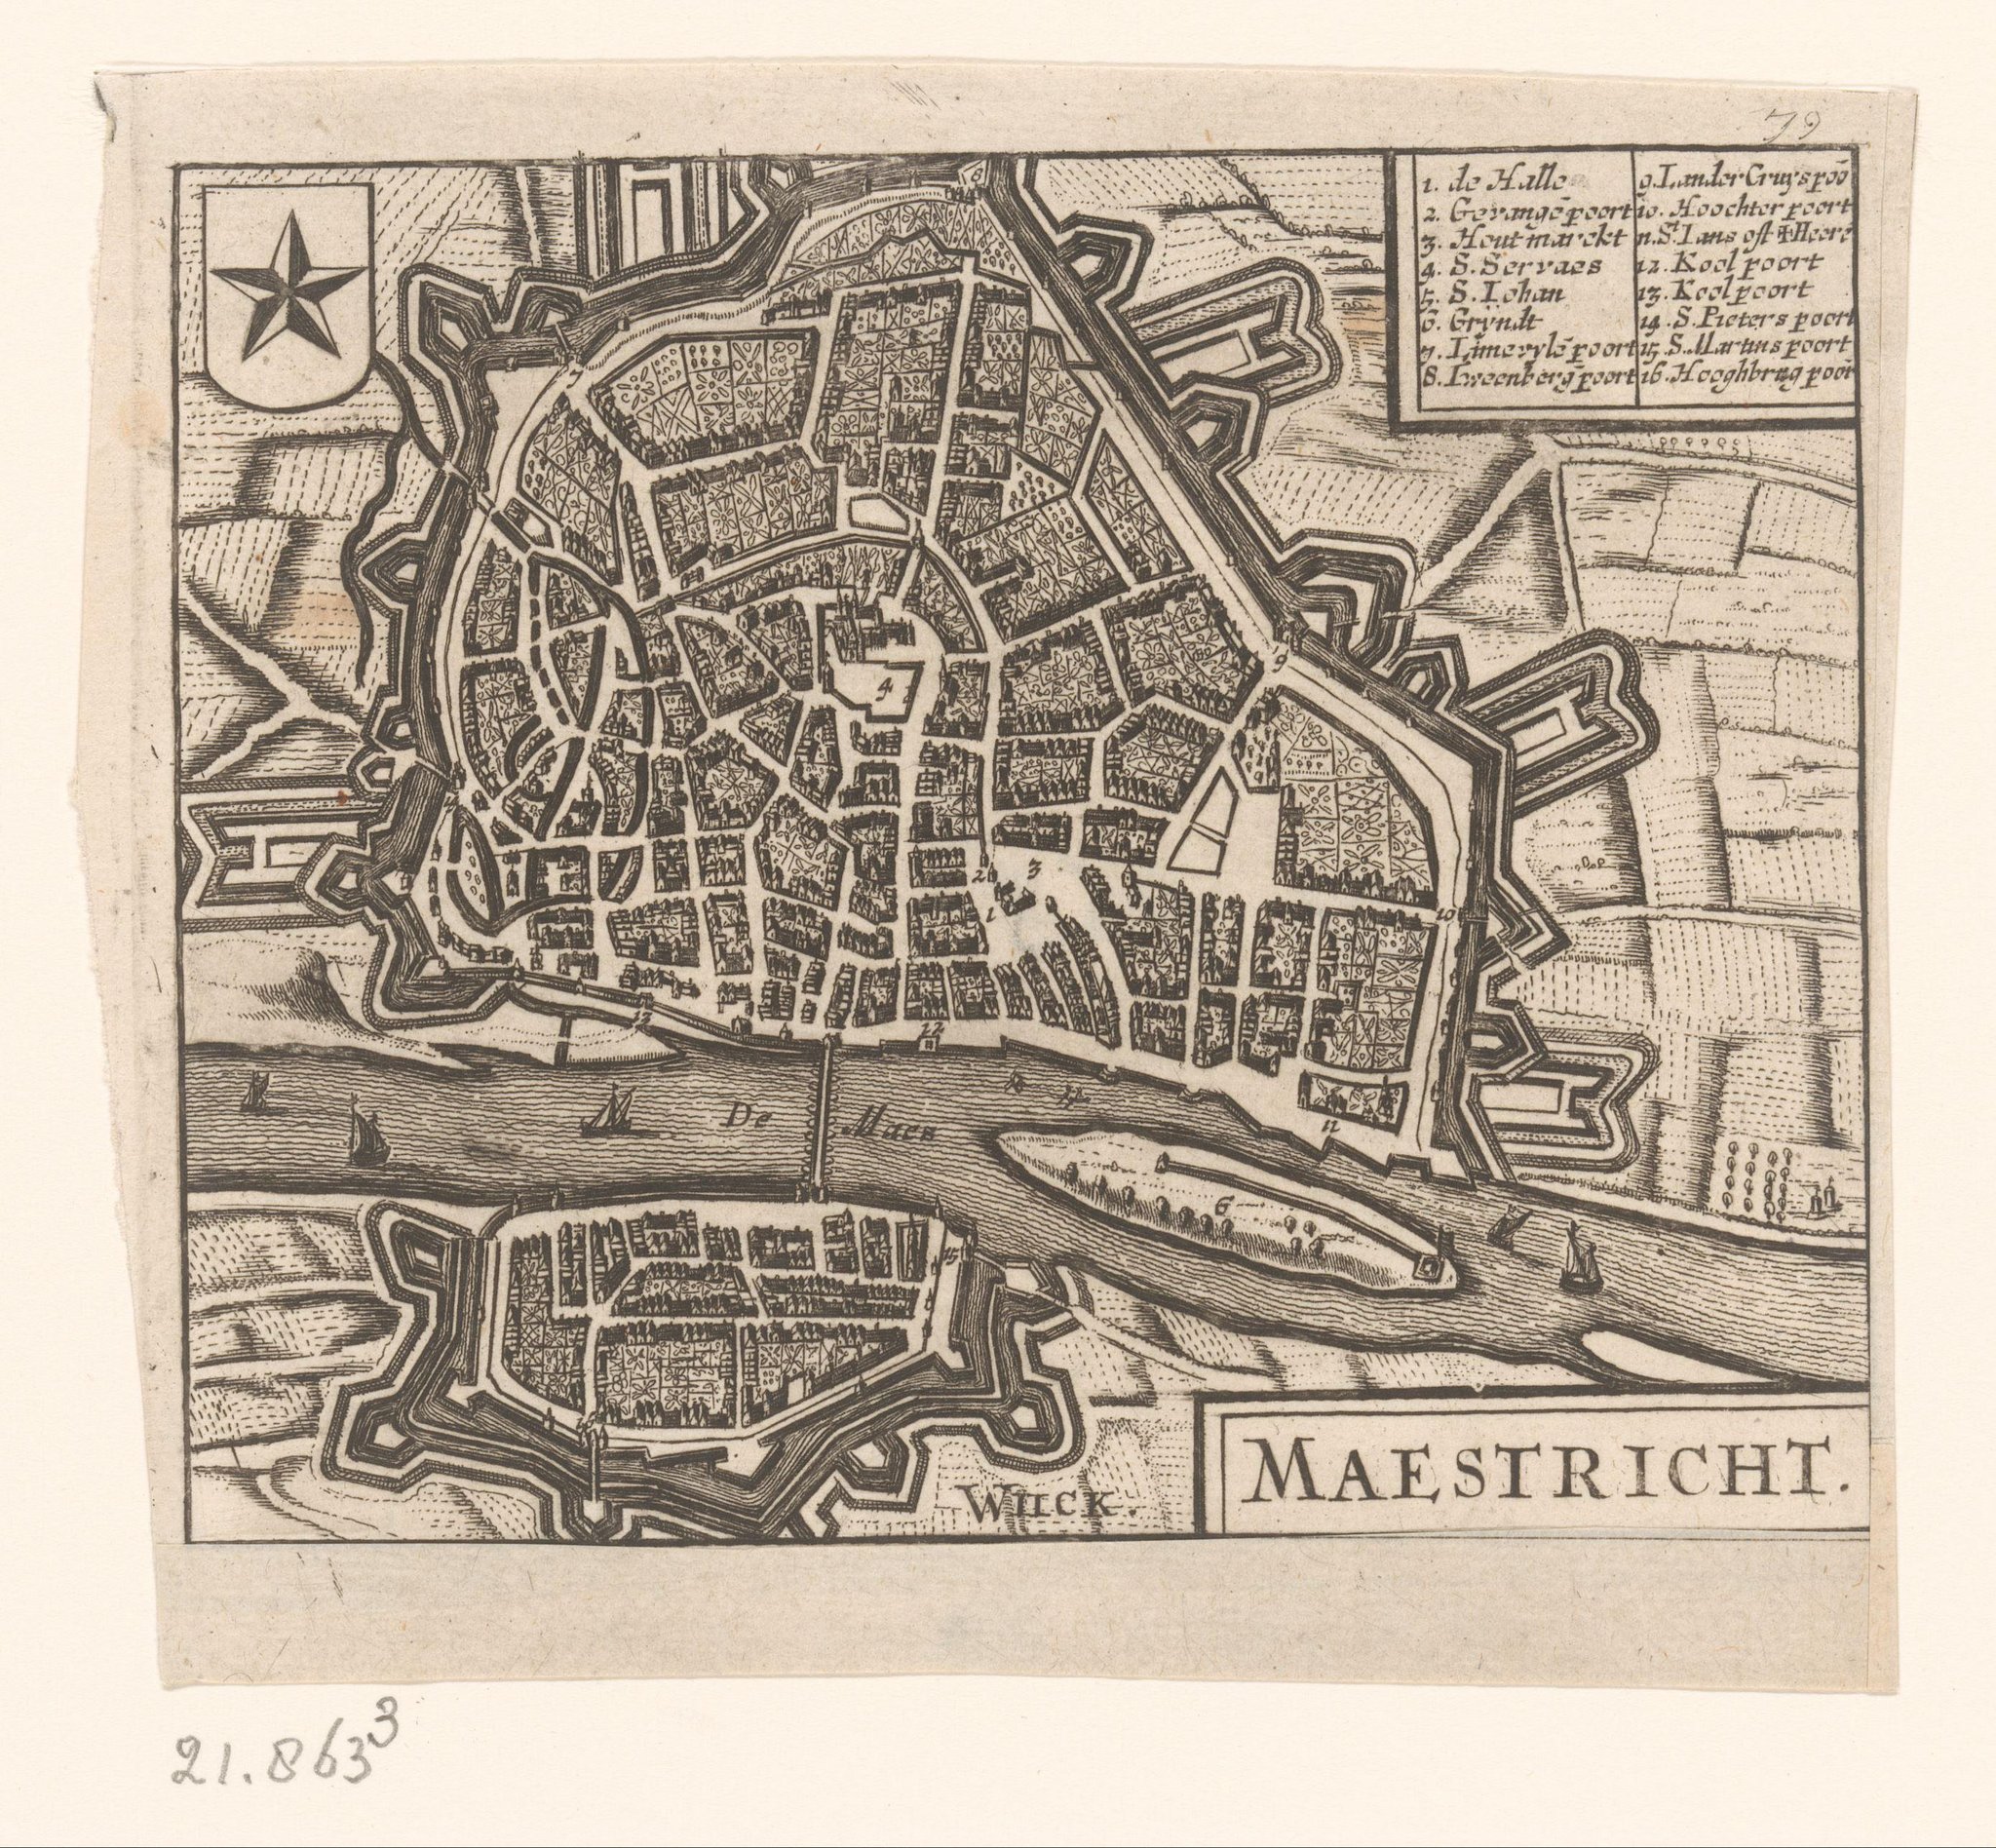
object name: book illustration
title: Plattegrond van Maastricht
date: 1660-1662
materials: paper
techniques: etching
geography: netherlands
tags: maps of cities, maastricht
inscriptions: collector's mark: Lugt 2228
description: Prent gebruikt in uitgaven van: Guicciardini. Beschryvingh der Neder-landen (...). Amsterdam: Jacob van Meurs, 1660 en 1662.